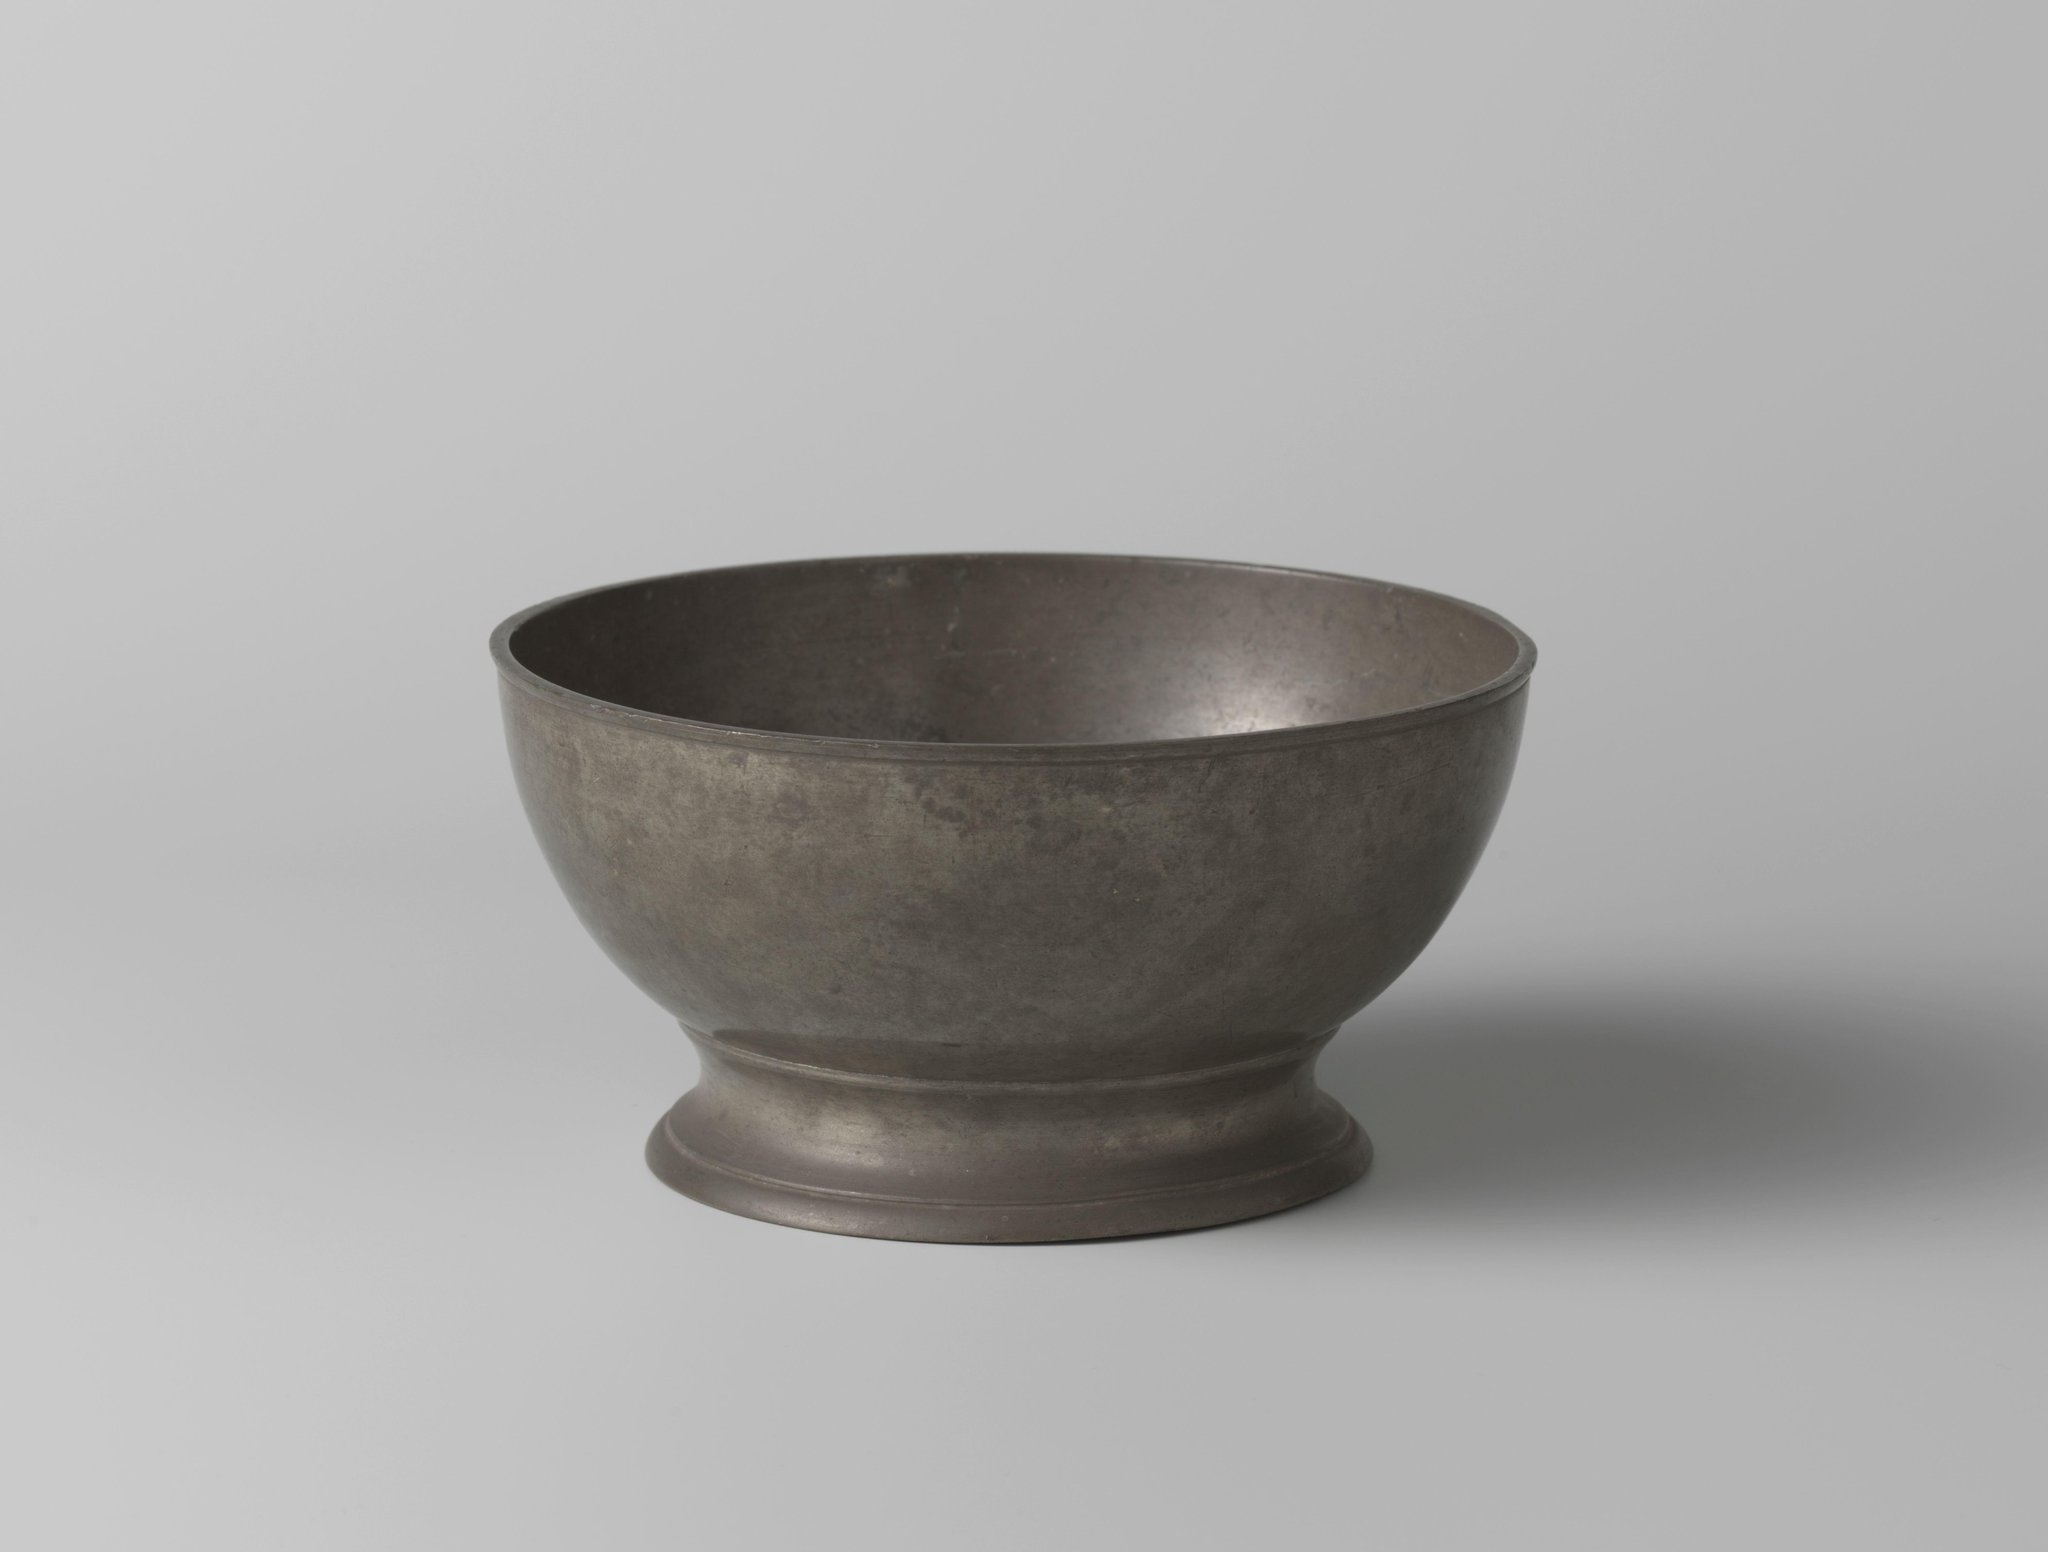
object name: bowl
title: Kom van tin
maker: hendrik bernardus buyn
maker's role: pewterers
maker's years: 1786-1847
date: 1810-1847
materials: tin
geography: utrecht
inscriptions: quality mark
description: Kom van tin. De voet en de overgang van voet naar kom zijn geprofileerd met een horizontale baan. De bovenrand is iets verdikt en rond om omgeslagen.